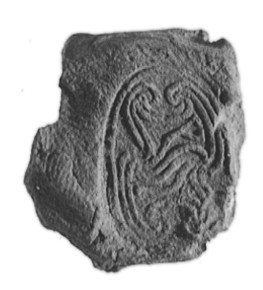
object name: sealing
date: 2030-1640 BCE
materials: clay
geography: egypt